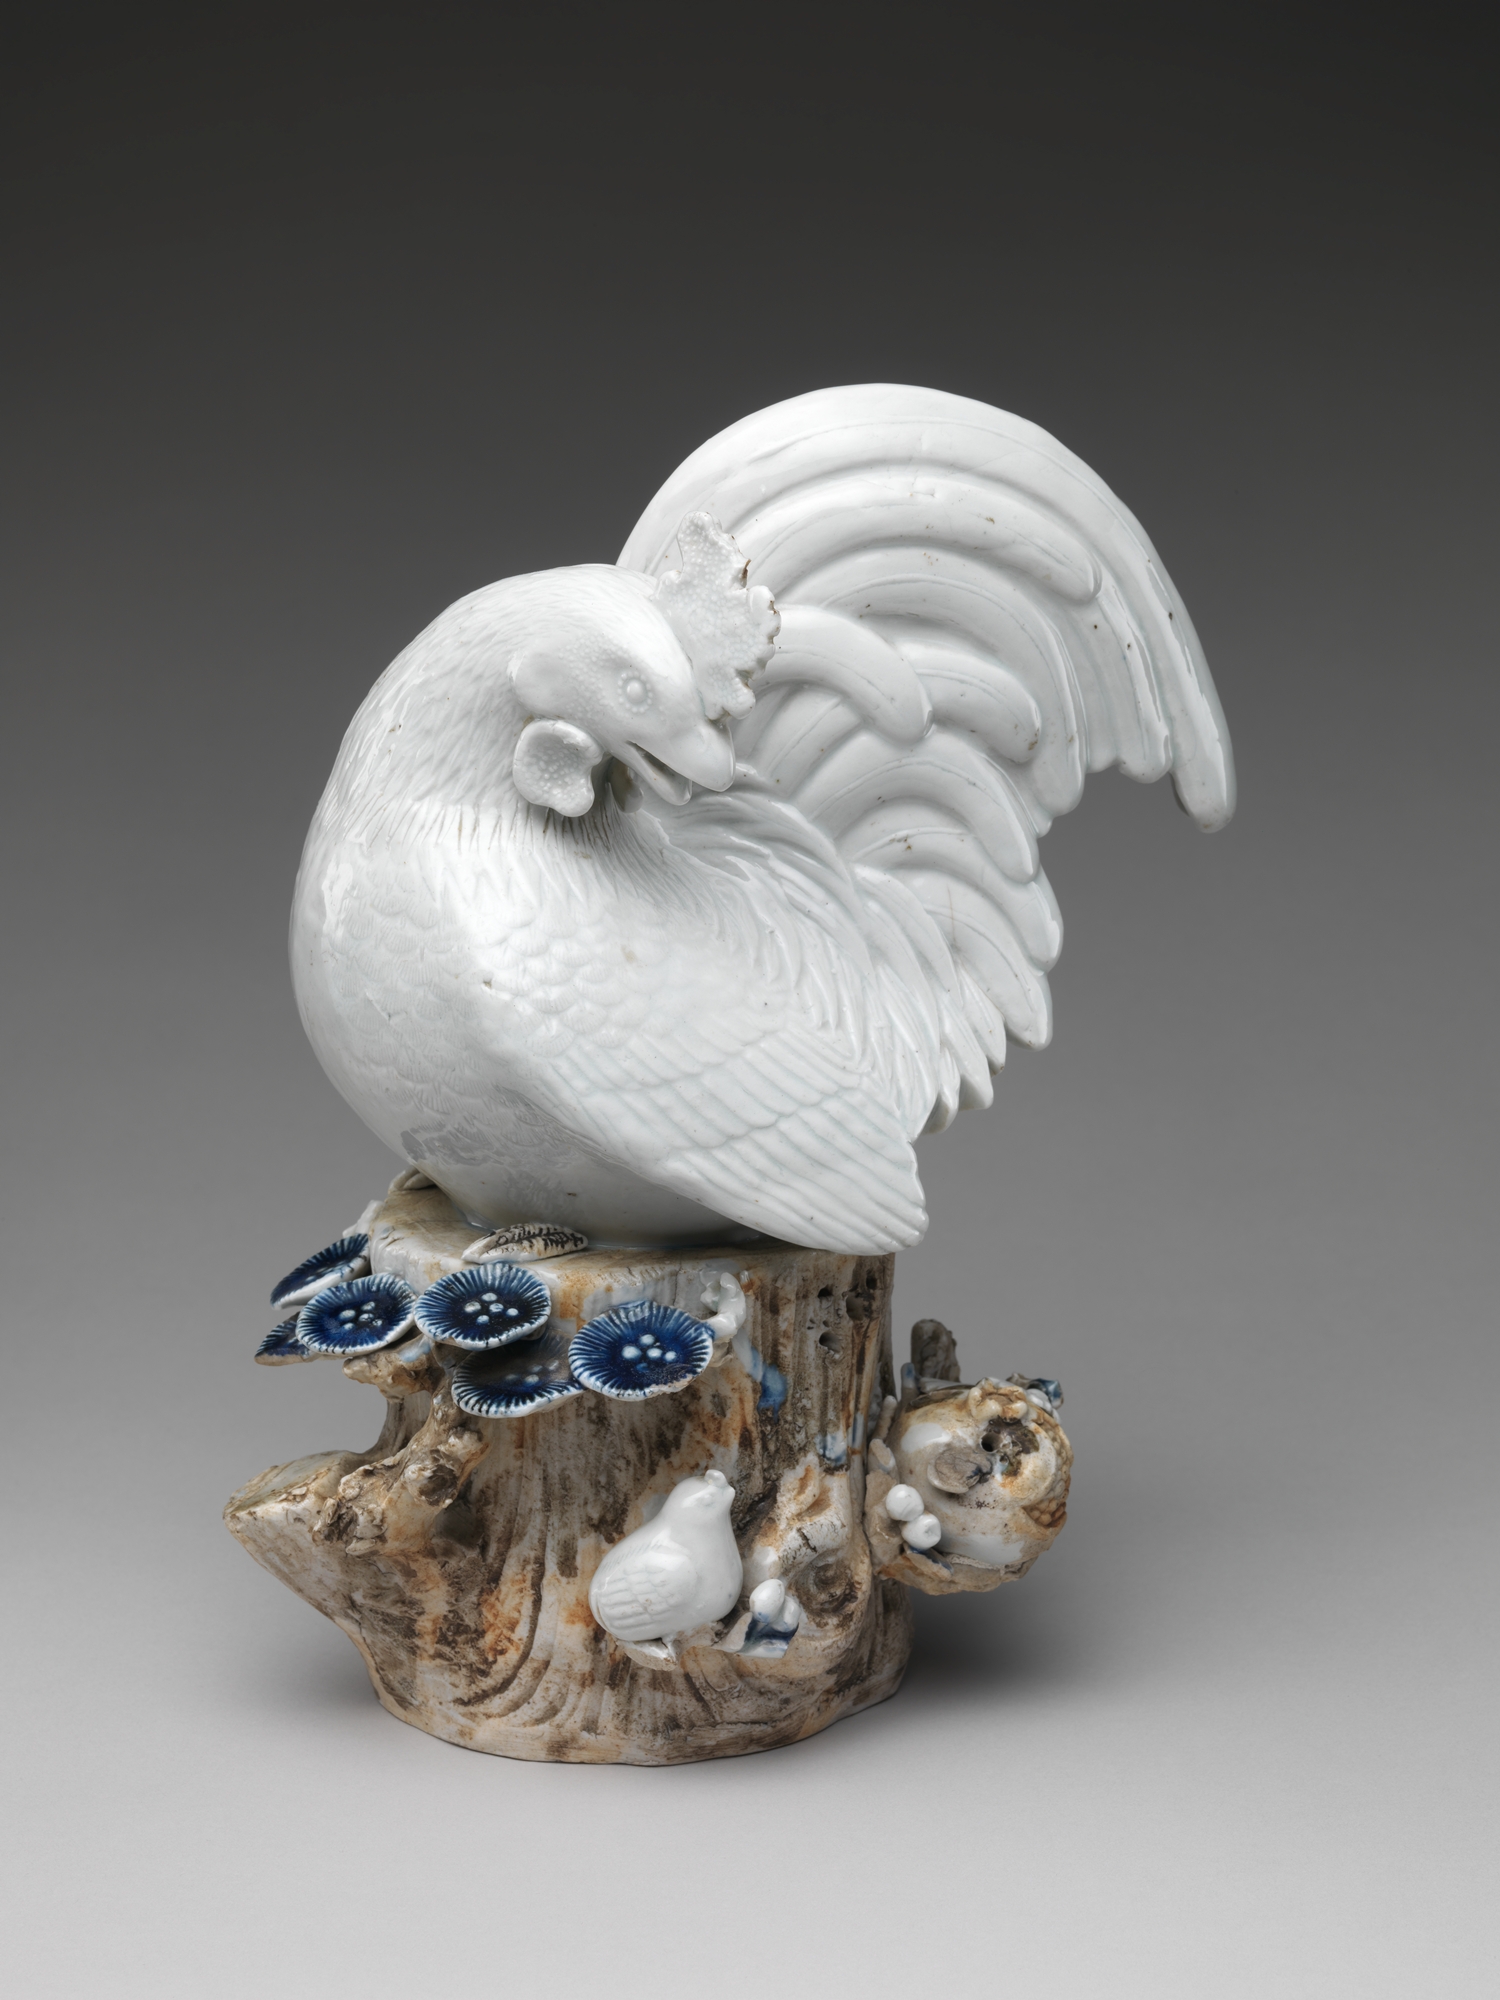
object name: ceramic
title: Hen with Chicks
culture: japanese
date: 1667-1733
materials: porcelain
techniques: underglaze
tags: chickens